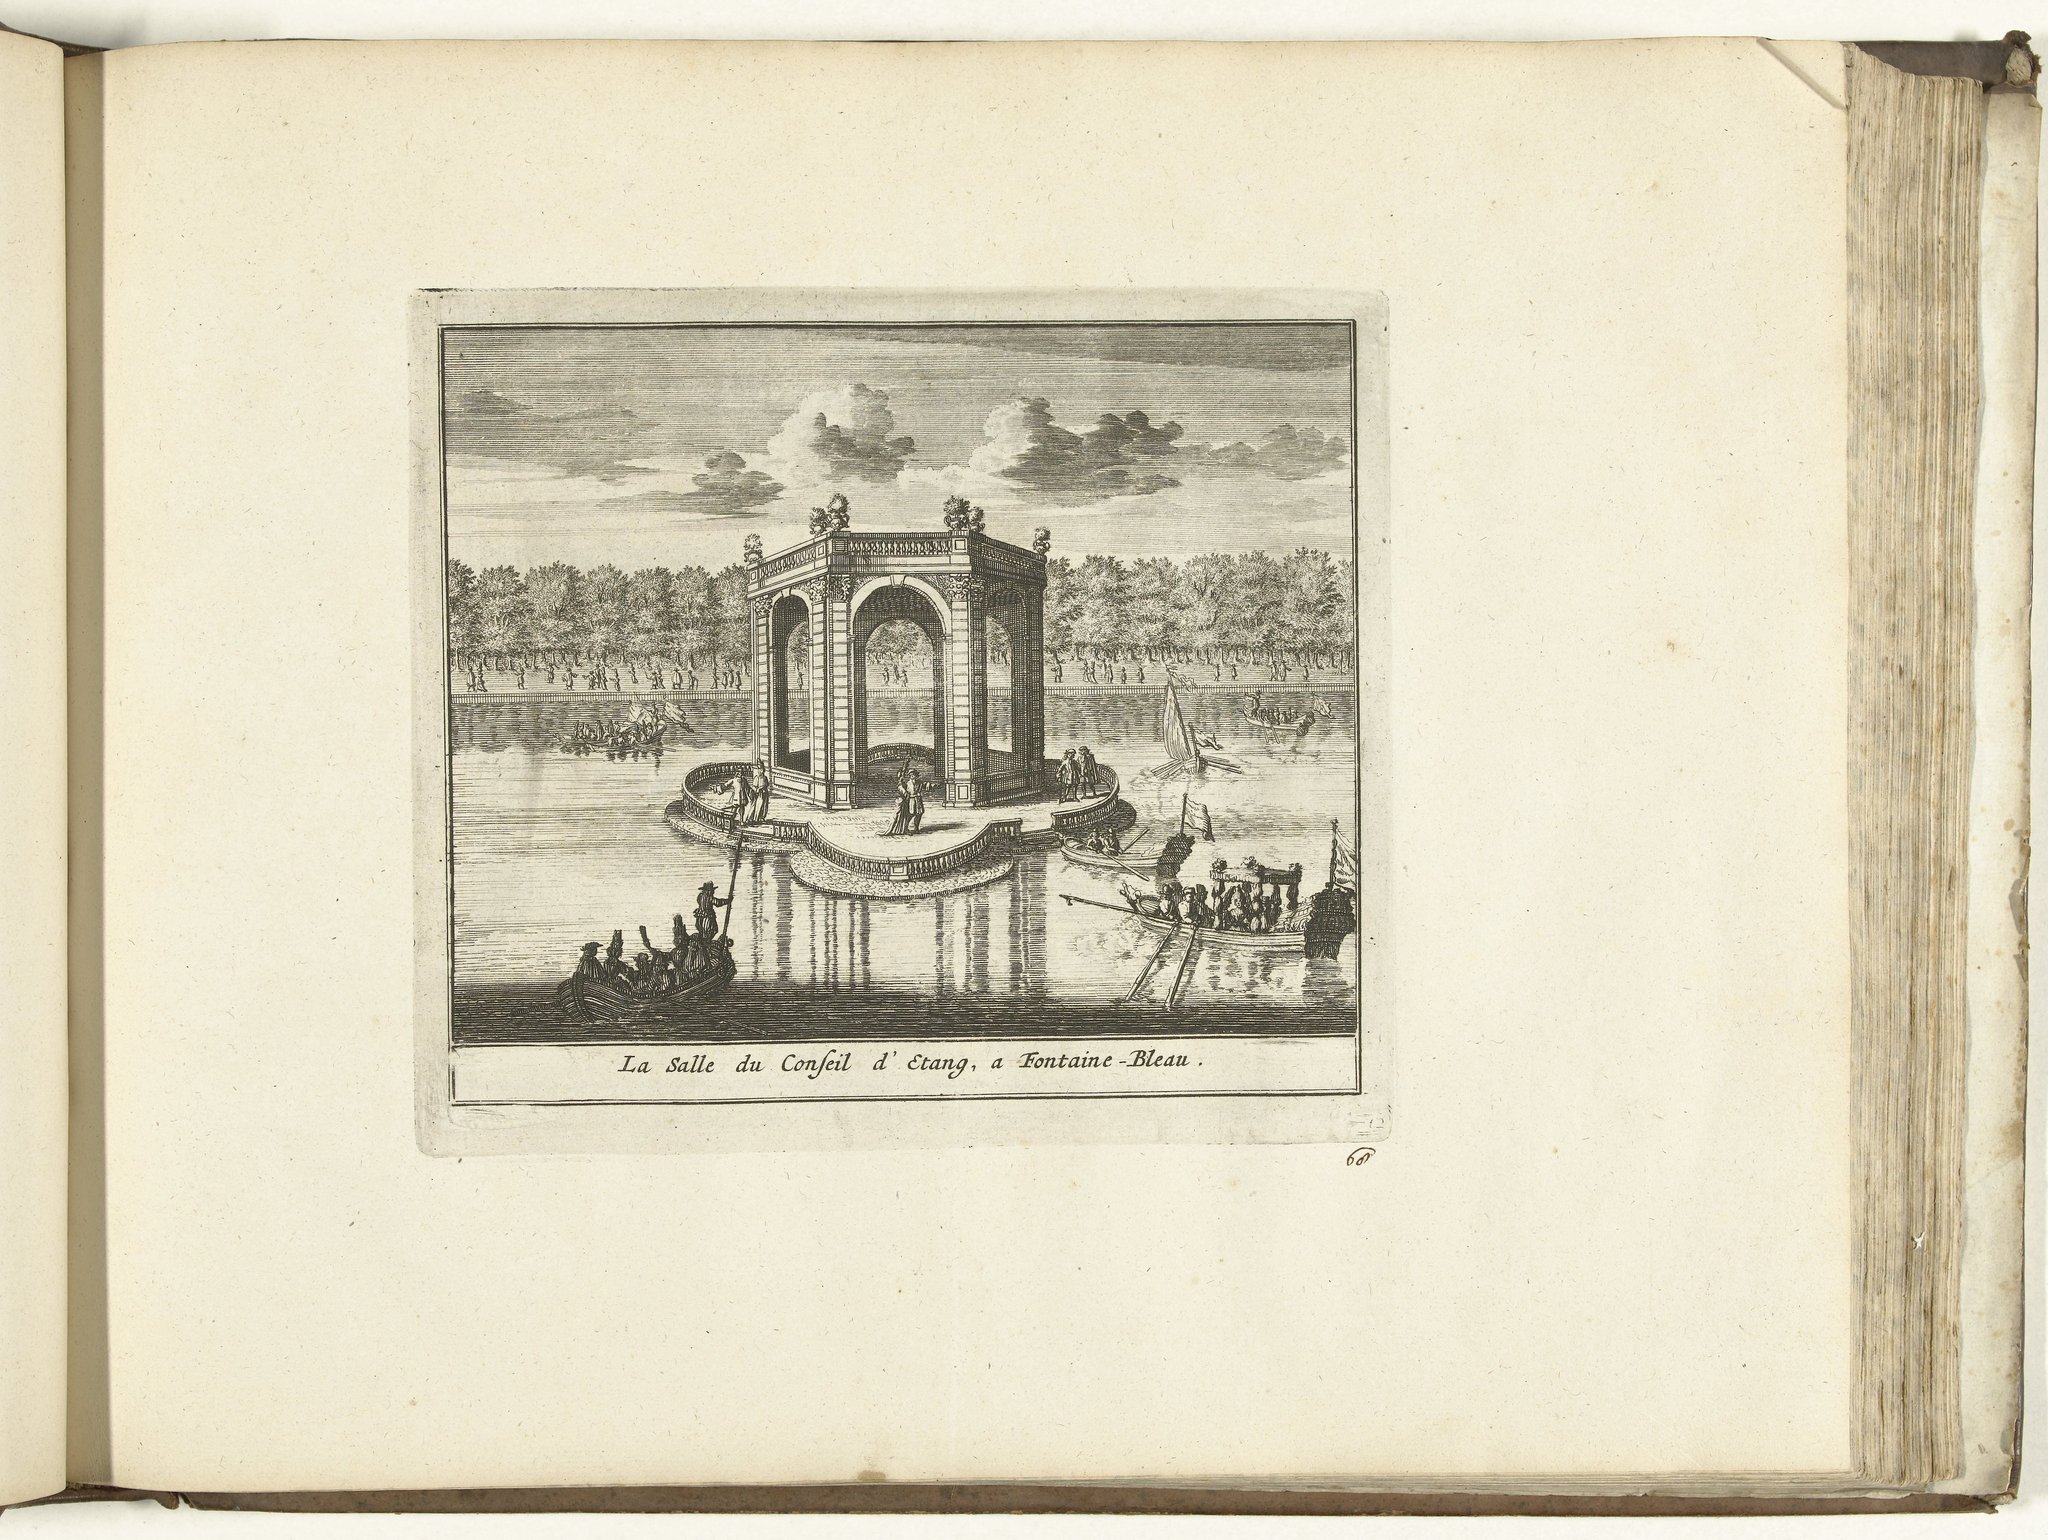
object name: print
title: Gezicht op de Salle de Conseil in de vijver in het paleis van Fontainebleau, 1726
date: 1726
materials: paper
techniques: etching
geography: northern netherlands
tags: palace, garden buildings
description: Gezicht op de de Salle de Conseil, een parkgebouw in de vijver van het paleis van Fontainebleau. Plaat nr. 68 in deel III van het prentwerk: Les Forces de l'Europe, Asie, Afrique et Amerique ... Comme aussi les Cartes des Côtes de France et d'Espagne uit 1726, dit eerste deel met 238 met de hand genummerde platen van vermaarde sterke steden en vestingen in het kader van de Spaanse Successieoorlog 1701-1713. Voor het merendeel zijn deze platen gekopieerd naar de anonieme Franse platen van vermaarde sterke steden en vestingen: in Les forces de l'Europe en in: Le theatre de la guerre, dans les Pays-Bas, beide oorspronkelijk uitgegeven door Nicolas de Fer te Parijs (1693-1697) in het kader van de Negenjarige Oorlog. Titel in het Frans. Rechtsonder sporen van een weggepolijste nummer: 12.